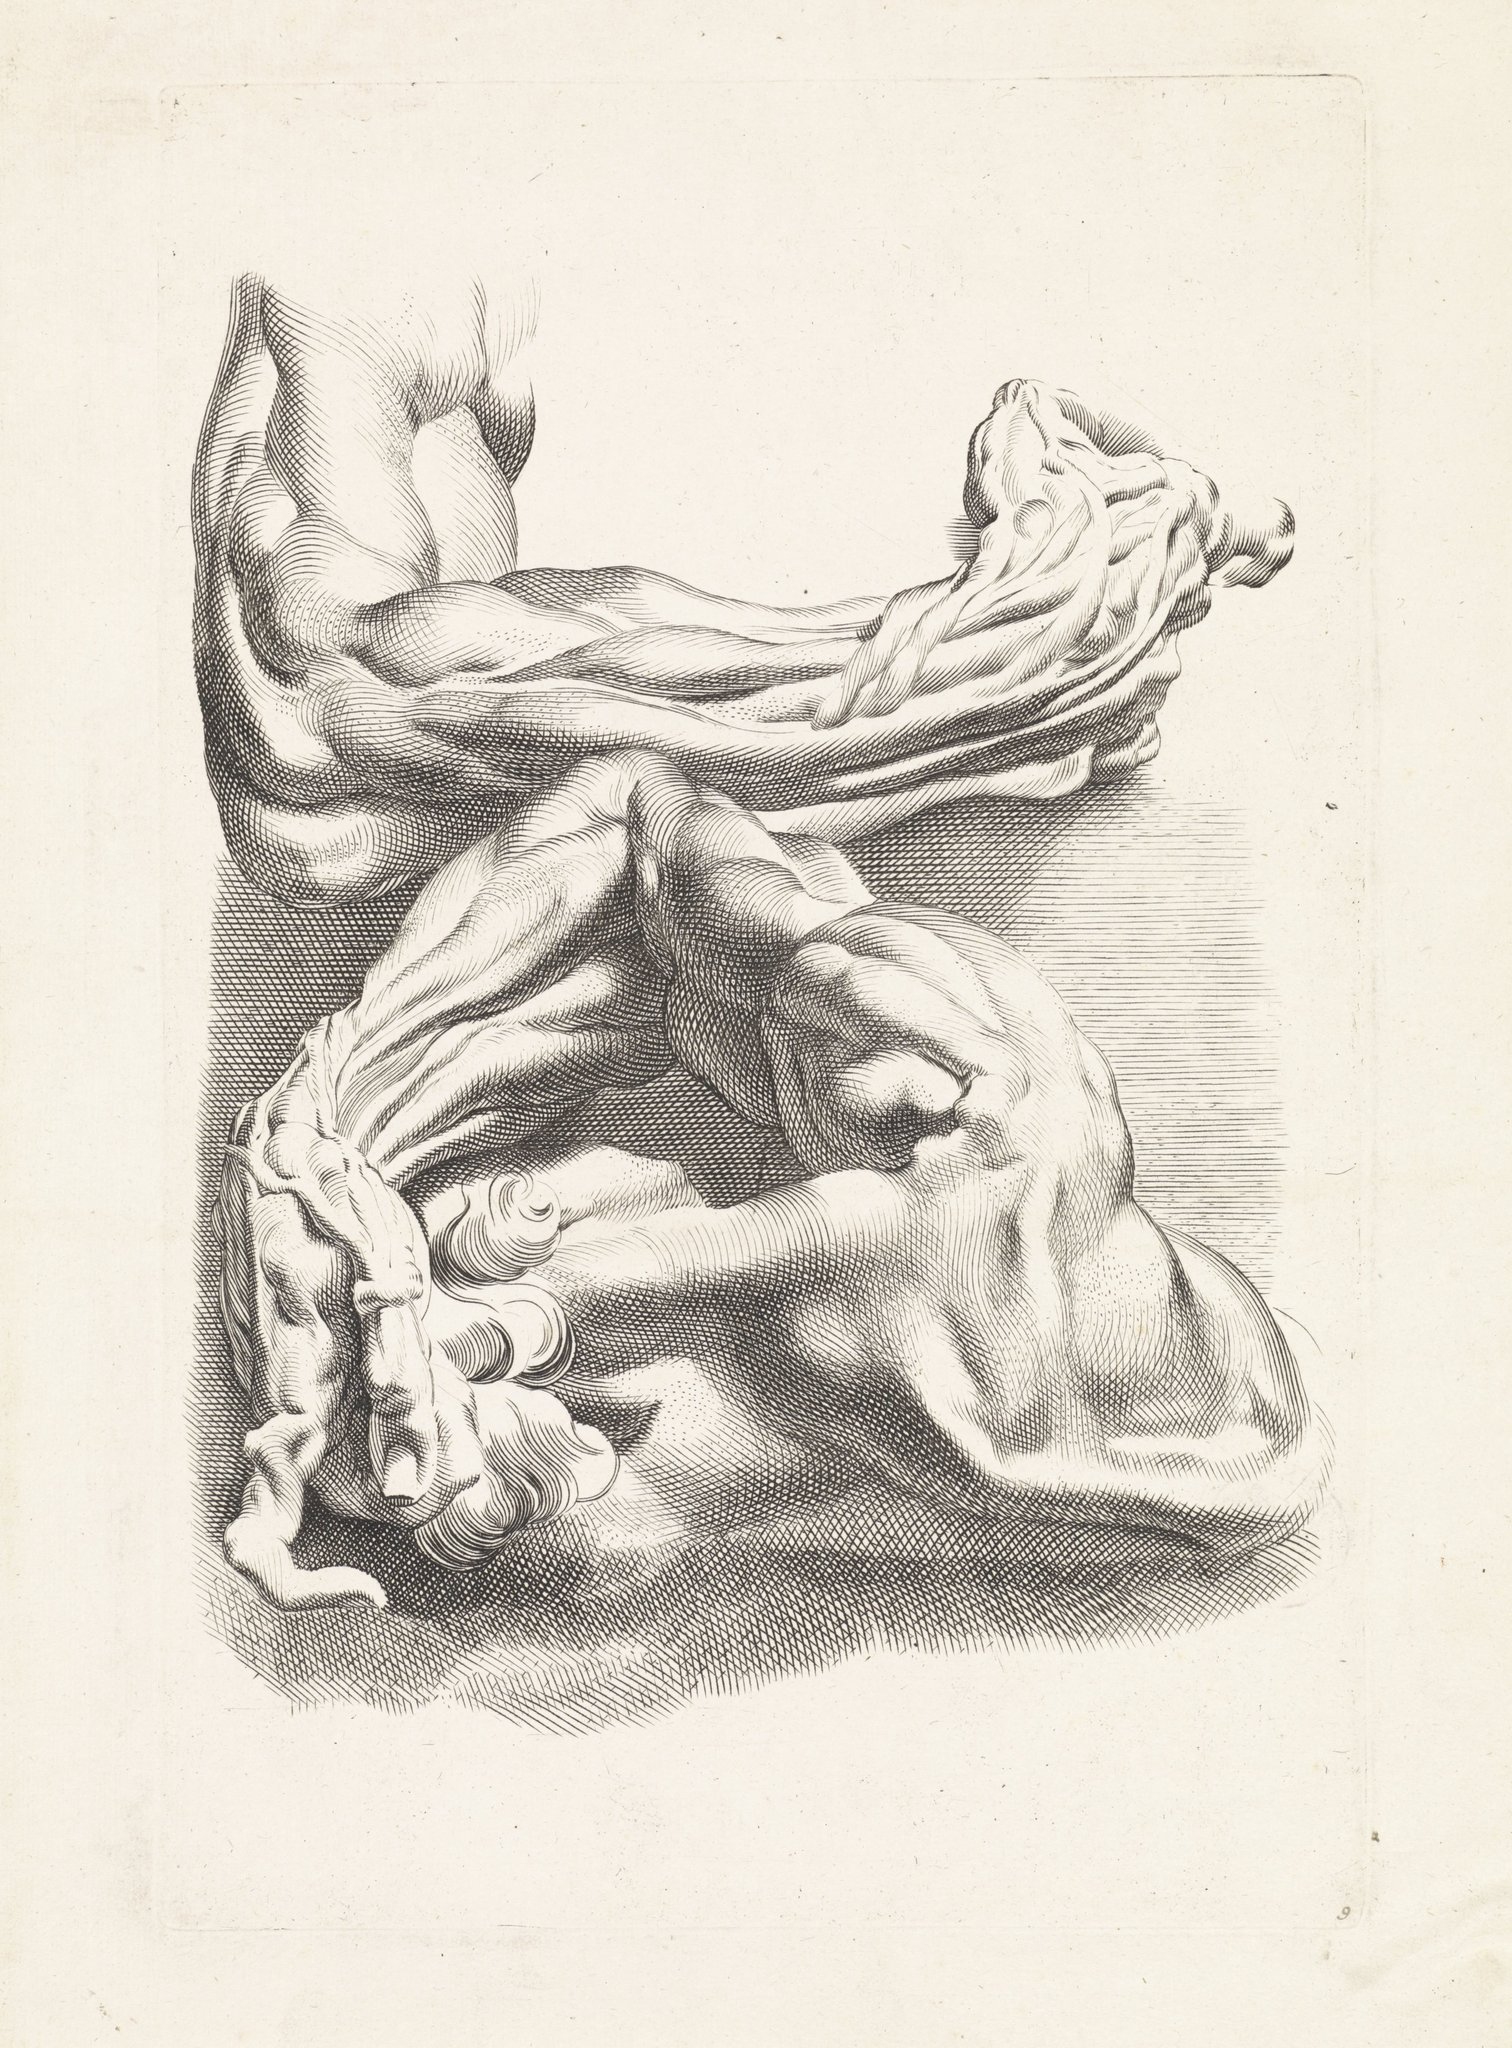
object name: print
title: Twee anatomische studies van armen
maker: paulus pontius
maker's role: draughtsman, print maker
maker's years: 1603-1658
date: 1616-1657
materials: paper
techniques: engraving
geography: antwerp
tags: arms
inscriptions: collector's mark: Lugt 240, number: ‘9’